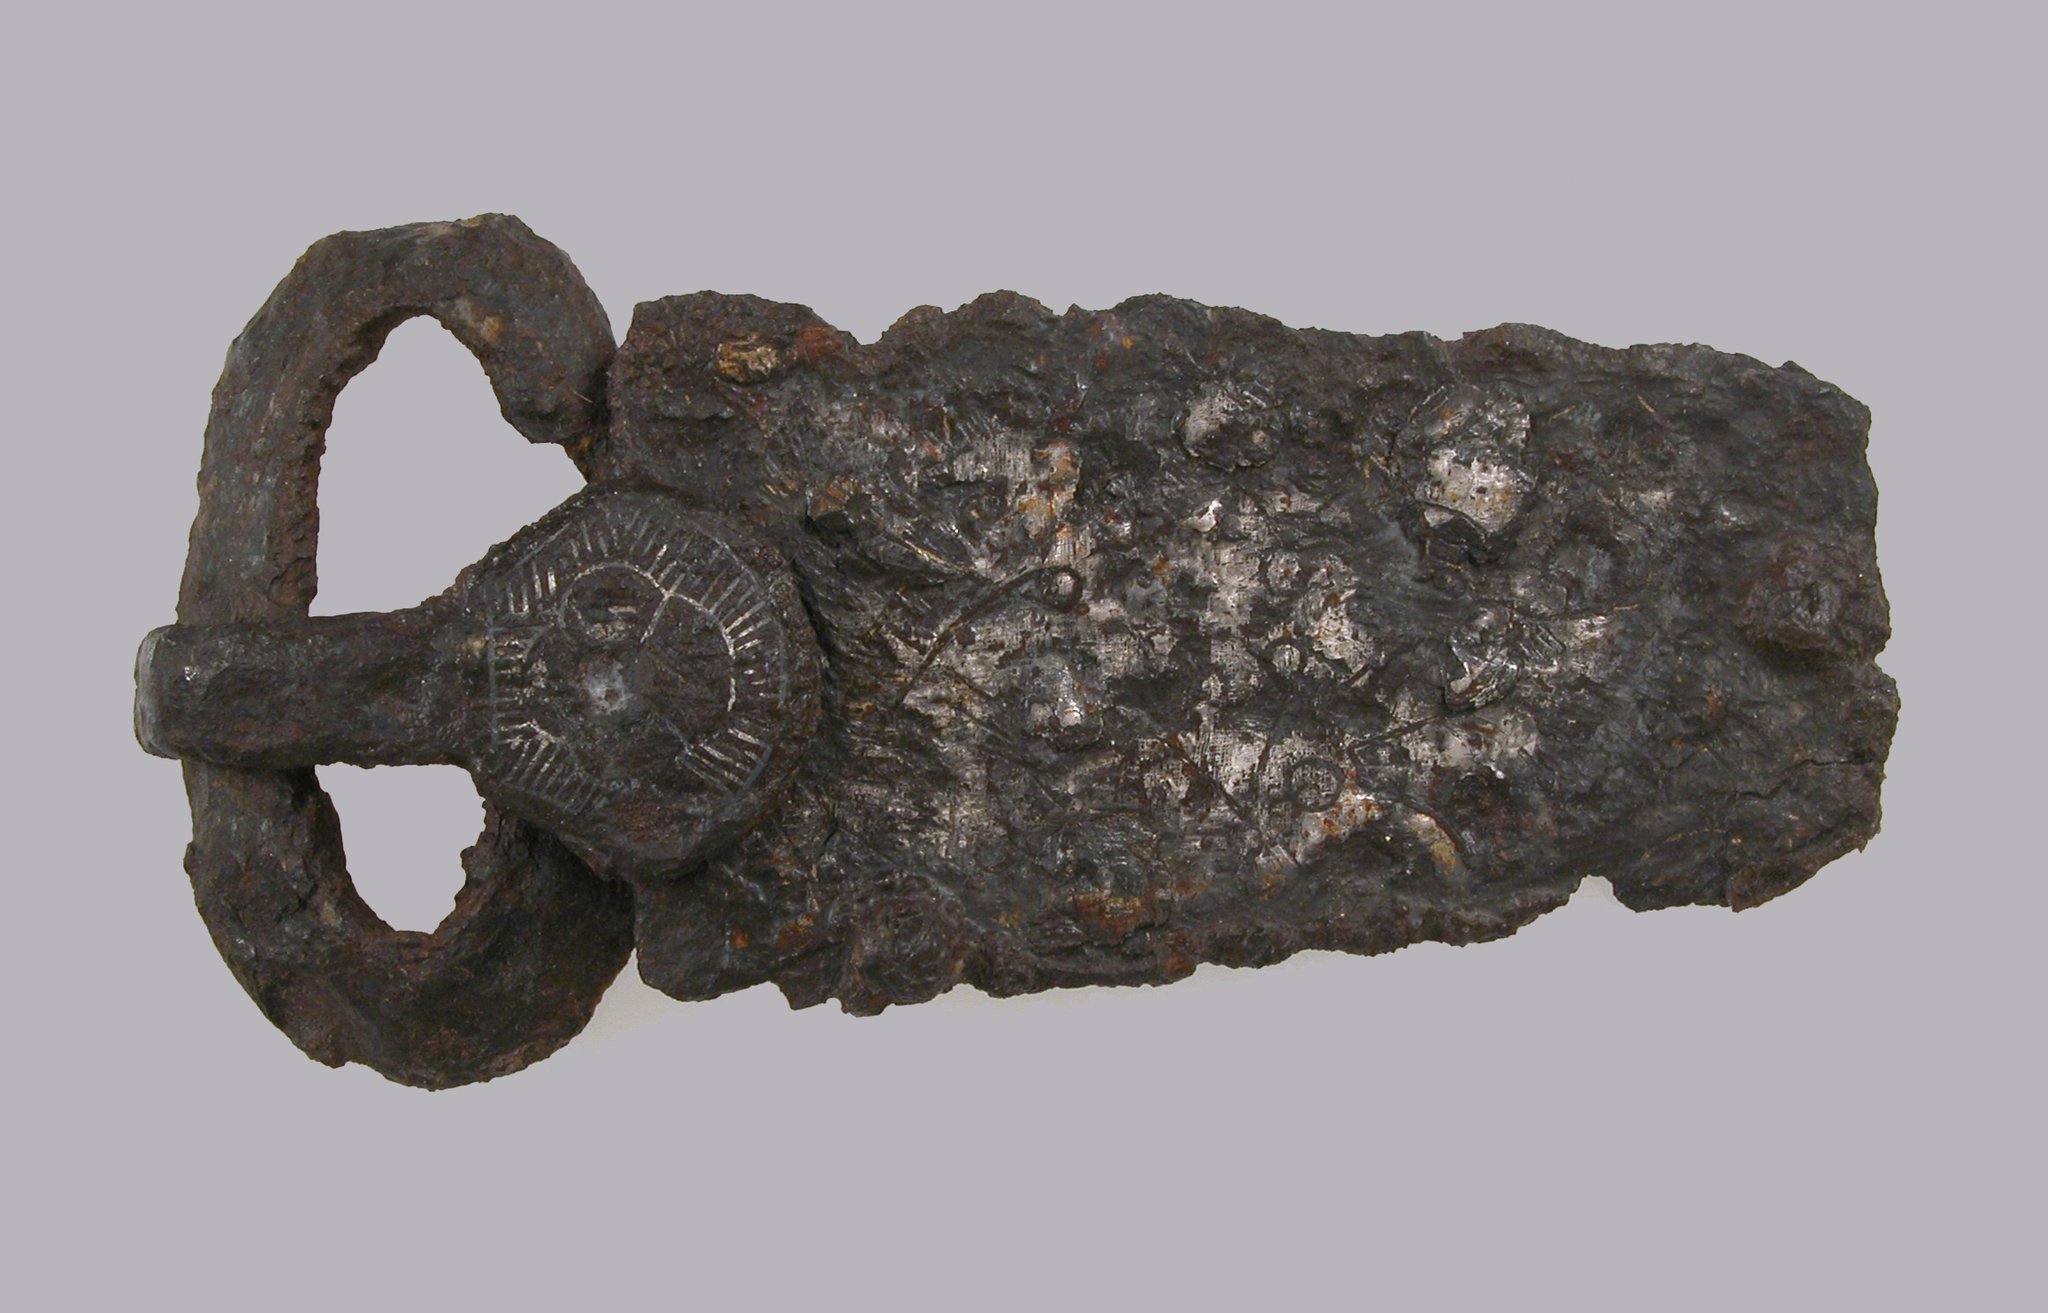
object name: belt buckle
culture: frankish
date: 601-700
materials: brass, iron, silver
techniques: inlay